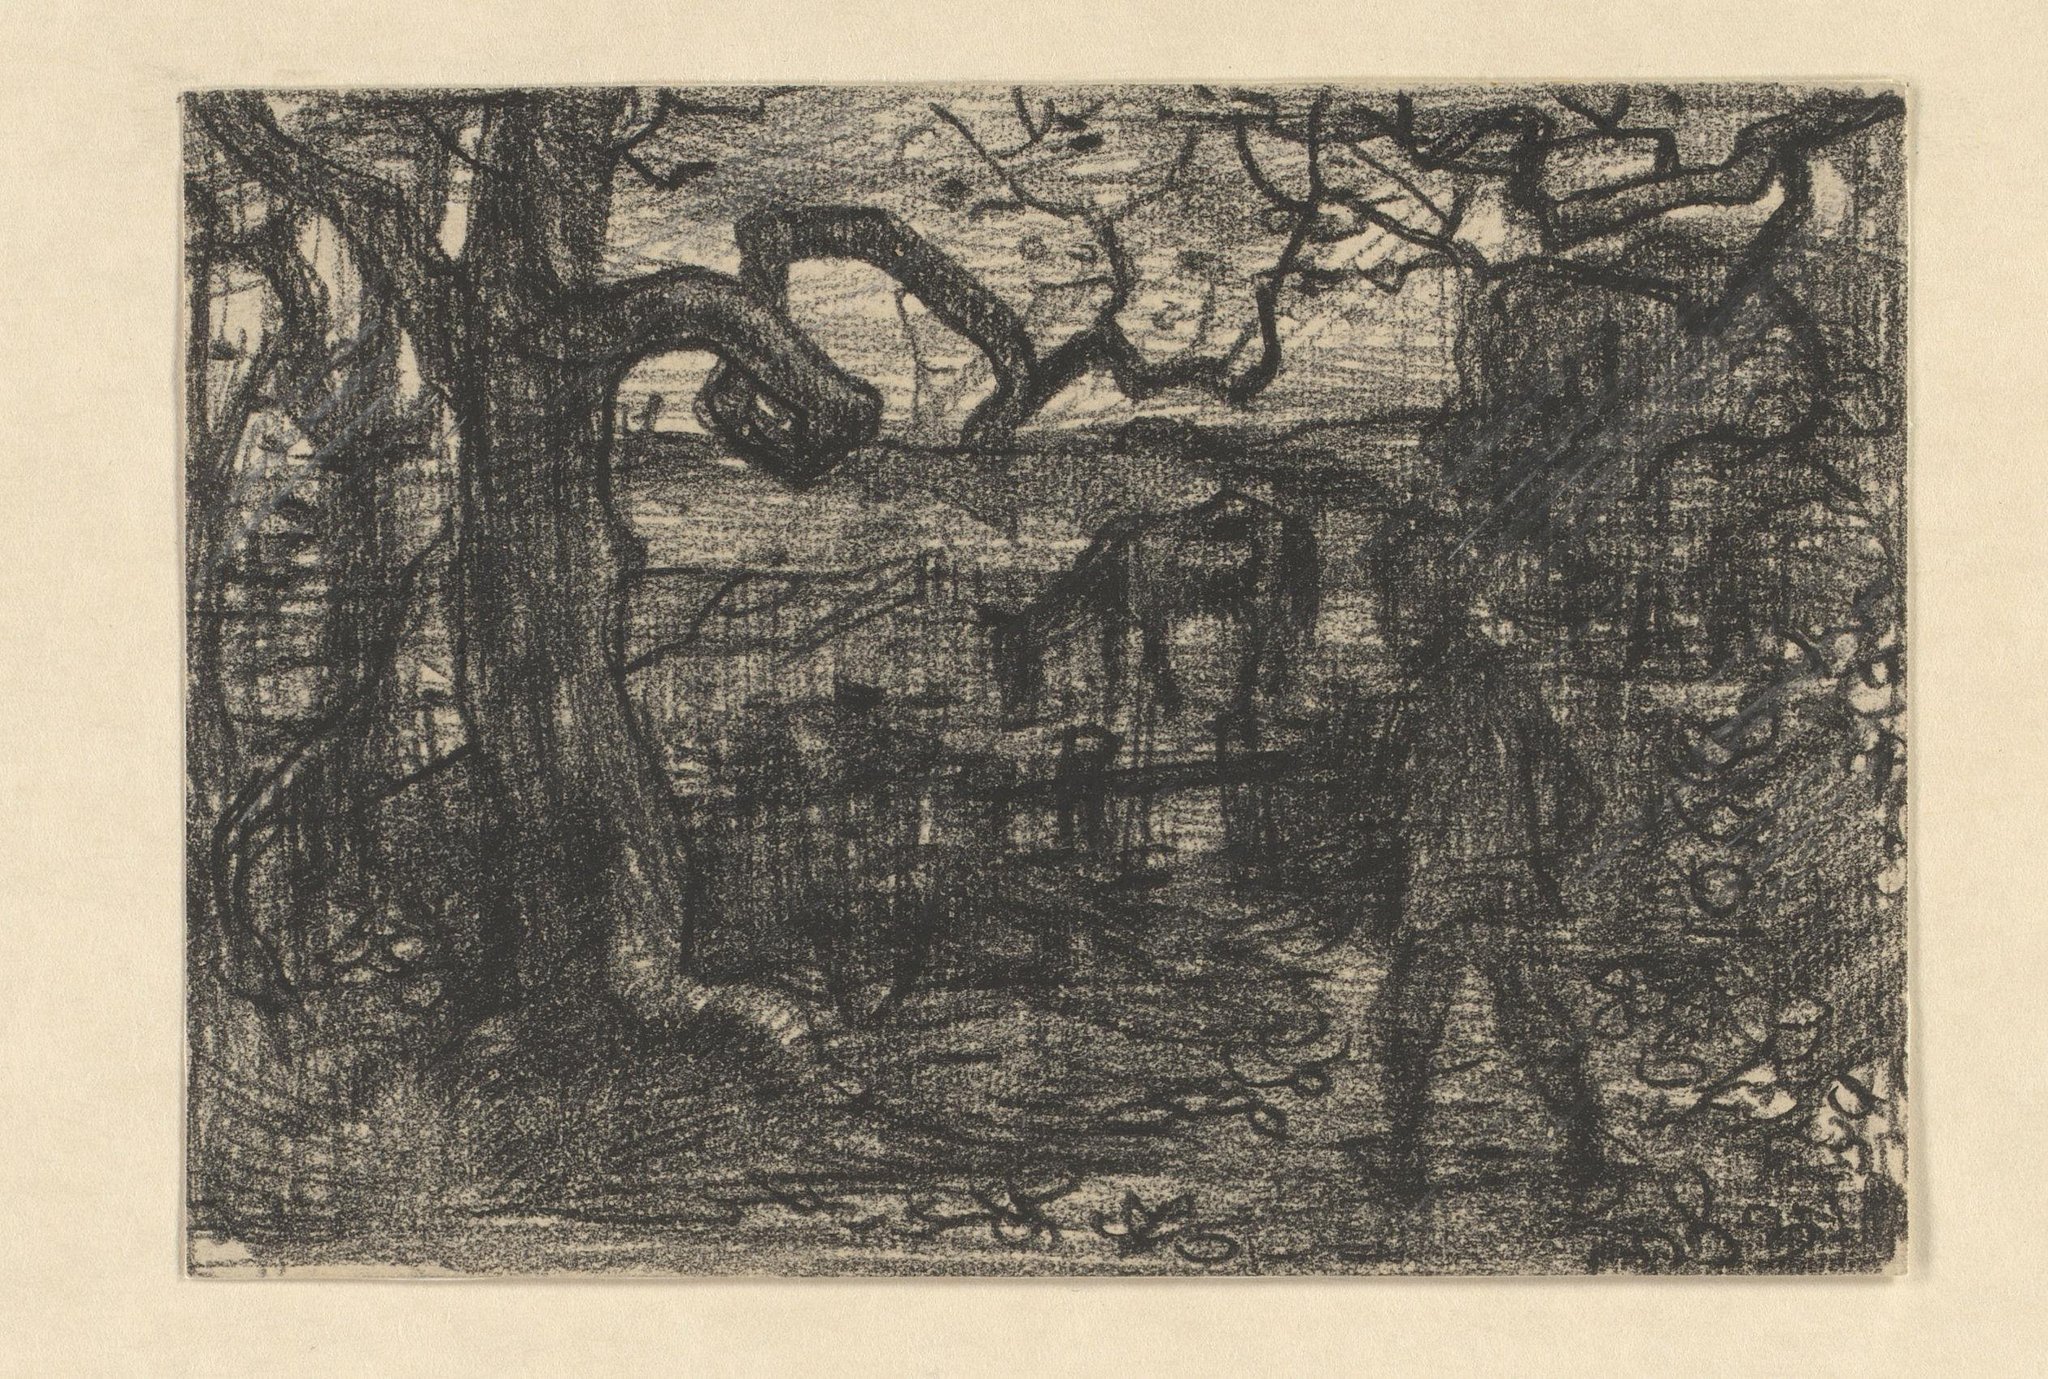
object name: drawing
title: Johannes aan de bosrand bij een paard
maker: edzard koning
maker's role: draughtsman, print maker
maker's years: 1869-1954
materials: chalk, paper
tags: trees, (van eeden, de kleine johannes) specific works of literature (with author, title), horse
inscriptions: collector's mark: Lugt 2228, inscription: ‘Paard te groot’, inscription: ‘Eindelijk kwam hij aan den boschrand. Hij zag over/ een weiland, waarop een fijne, klamme regen langzaam/ neerstreek. Er stond een paard midden in, enz.’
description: Ontwerp voor: Eeden, Frederik van. De kleine Johannes. Den Haag: Mouton & Co., 1898, p. 86. Niet gebruikt in de definitieve uitgave.